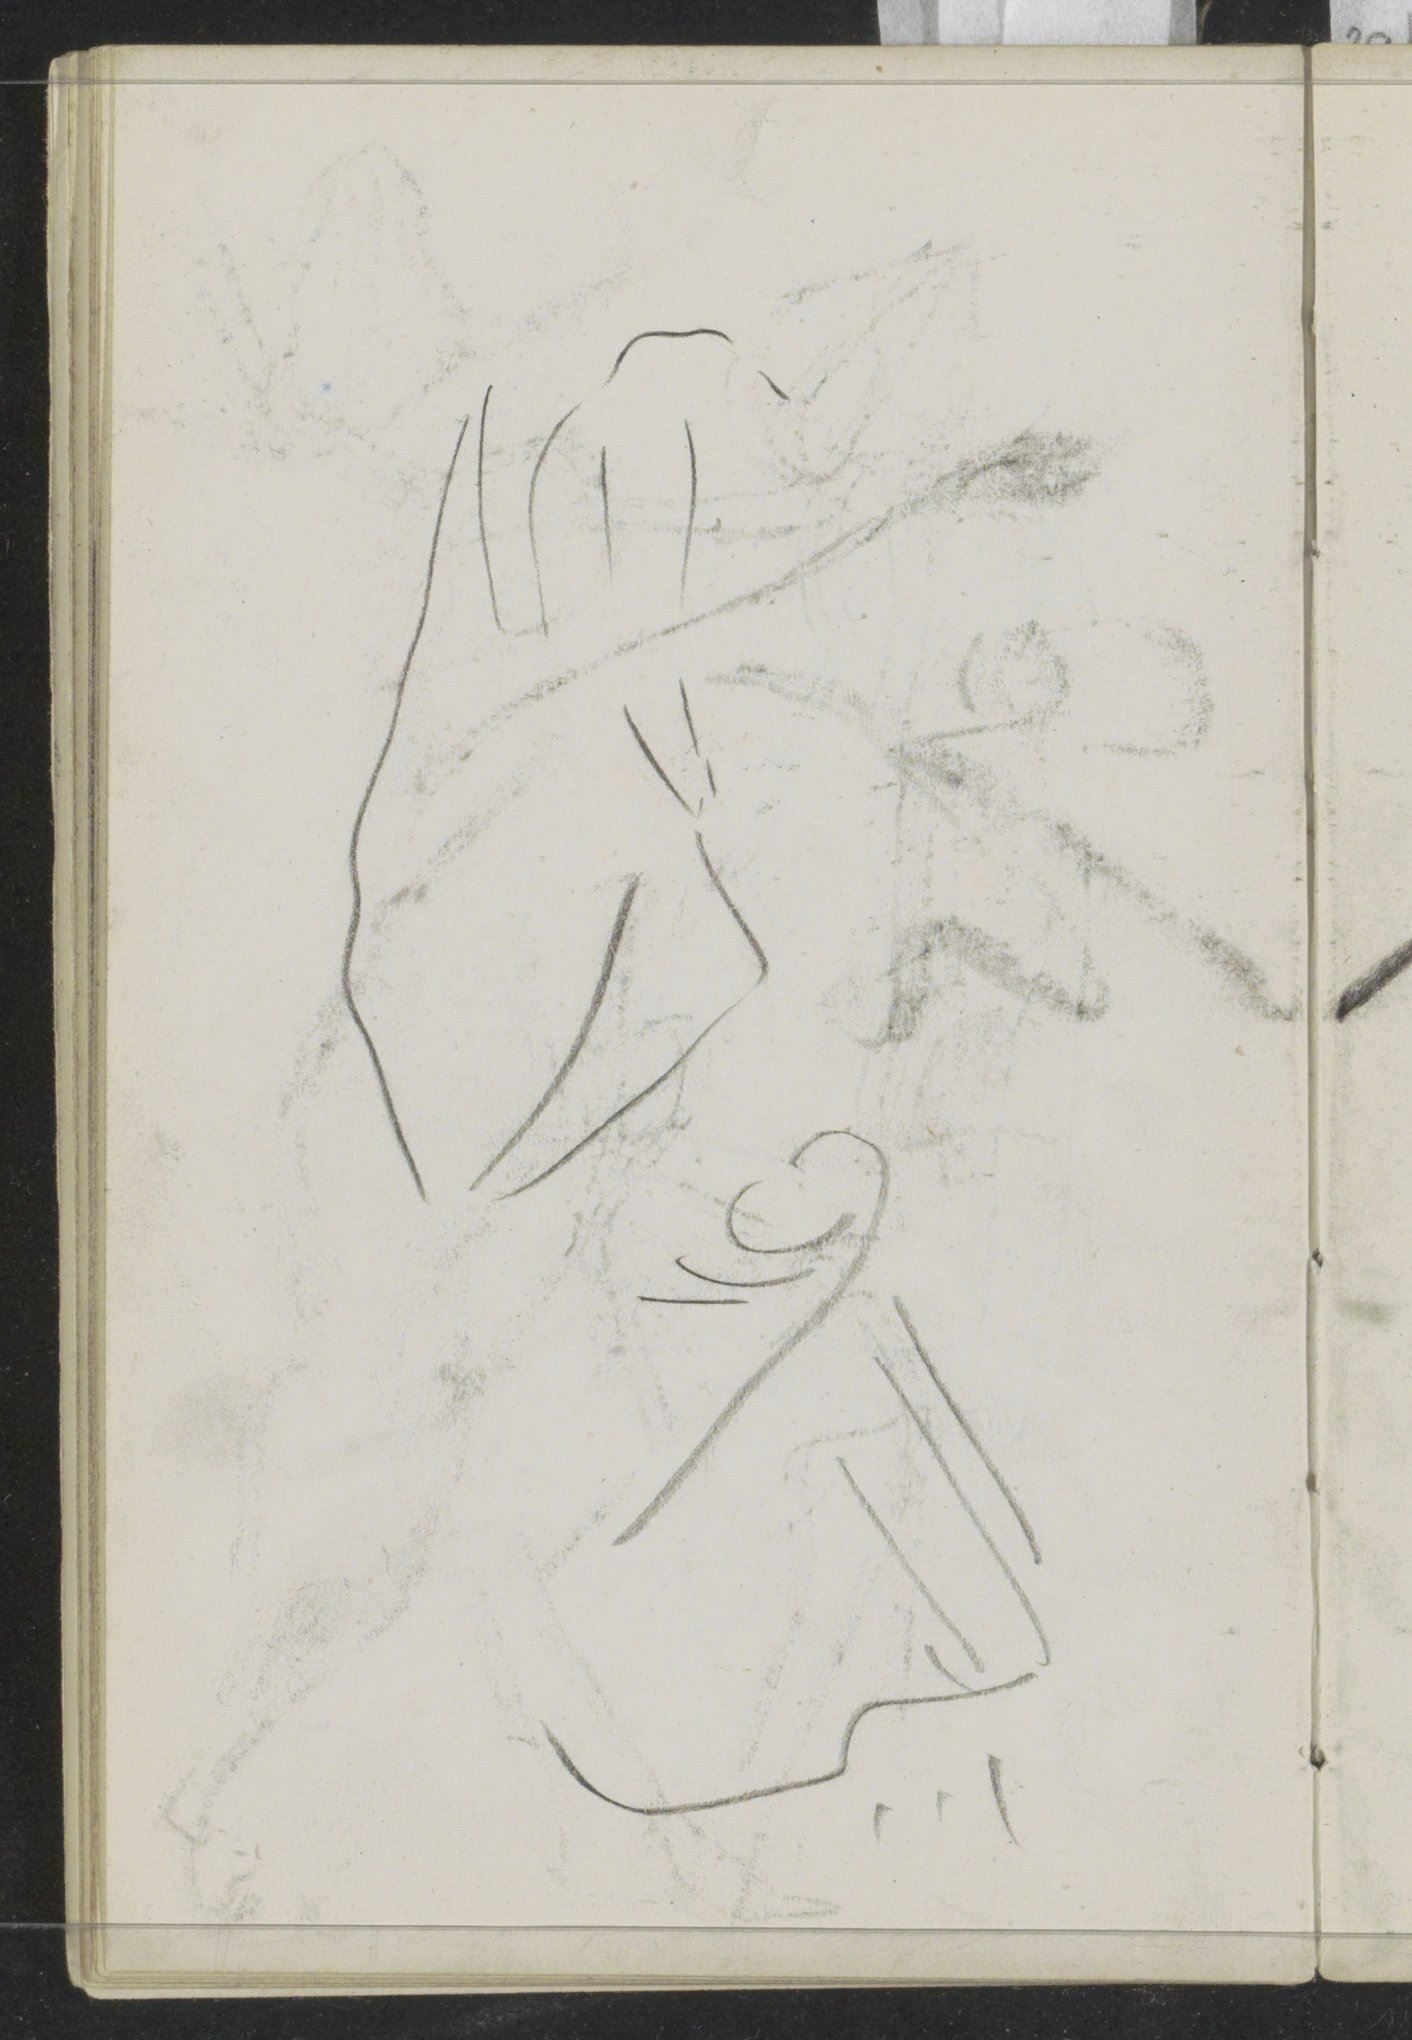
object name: sketchbook leaf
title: Studies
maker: carel adolph lion cachet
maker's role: draughtsman, print maker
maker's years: 1864-1945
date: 1874-1945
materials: chalk, paper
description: Blad 28 verso uit een schetsboek met 41 bladen.